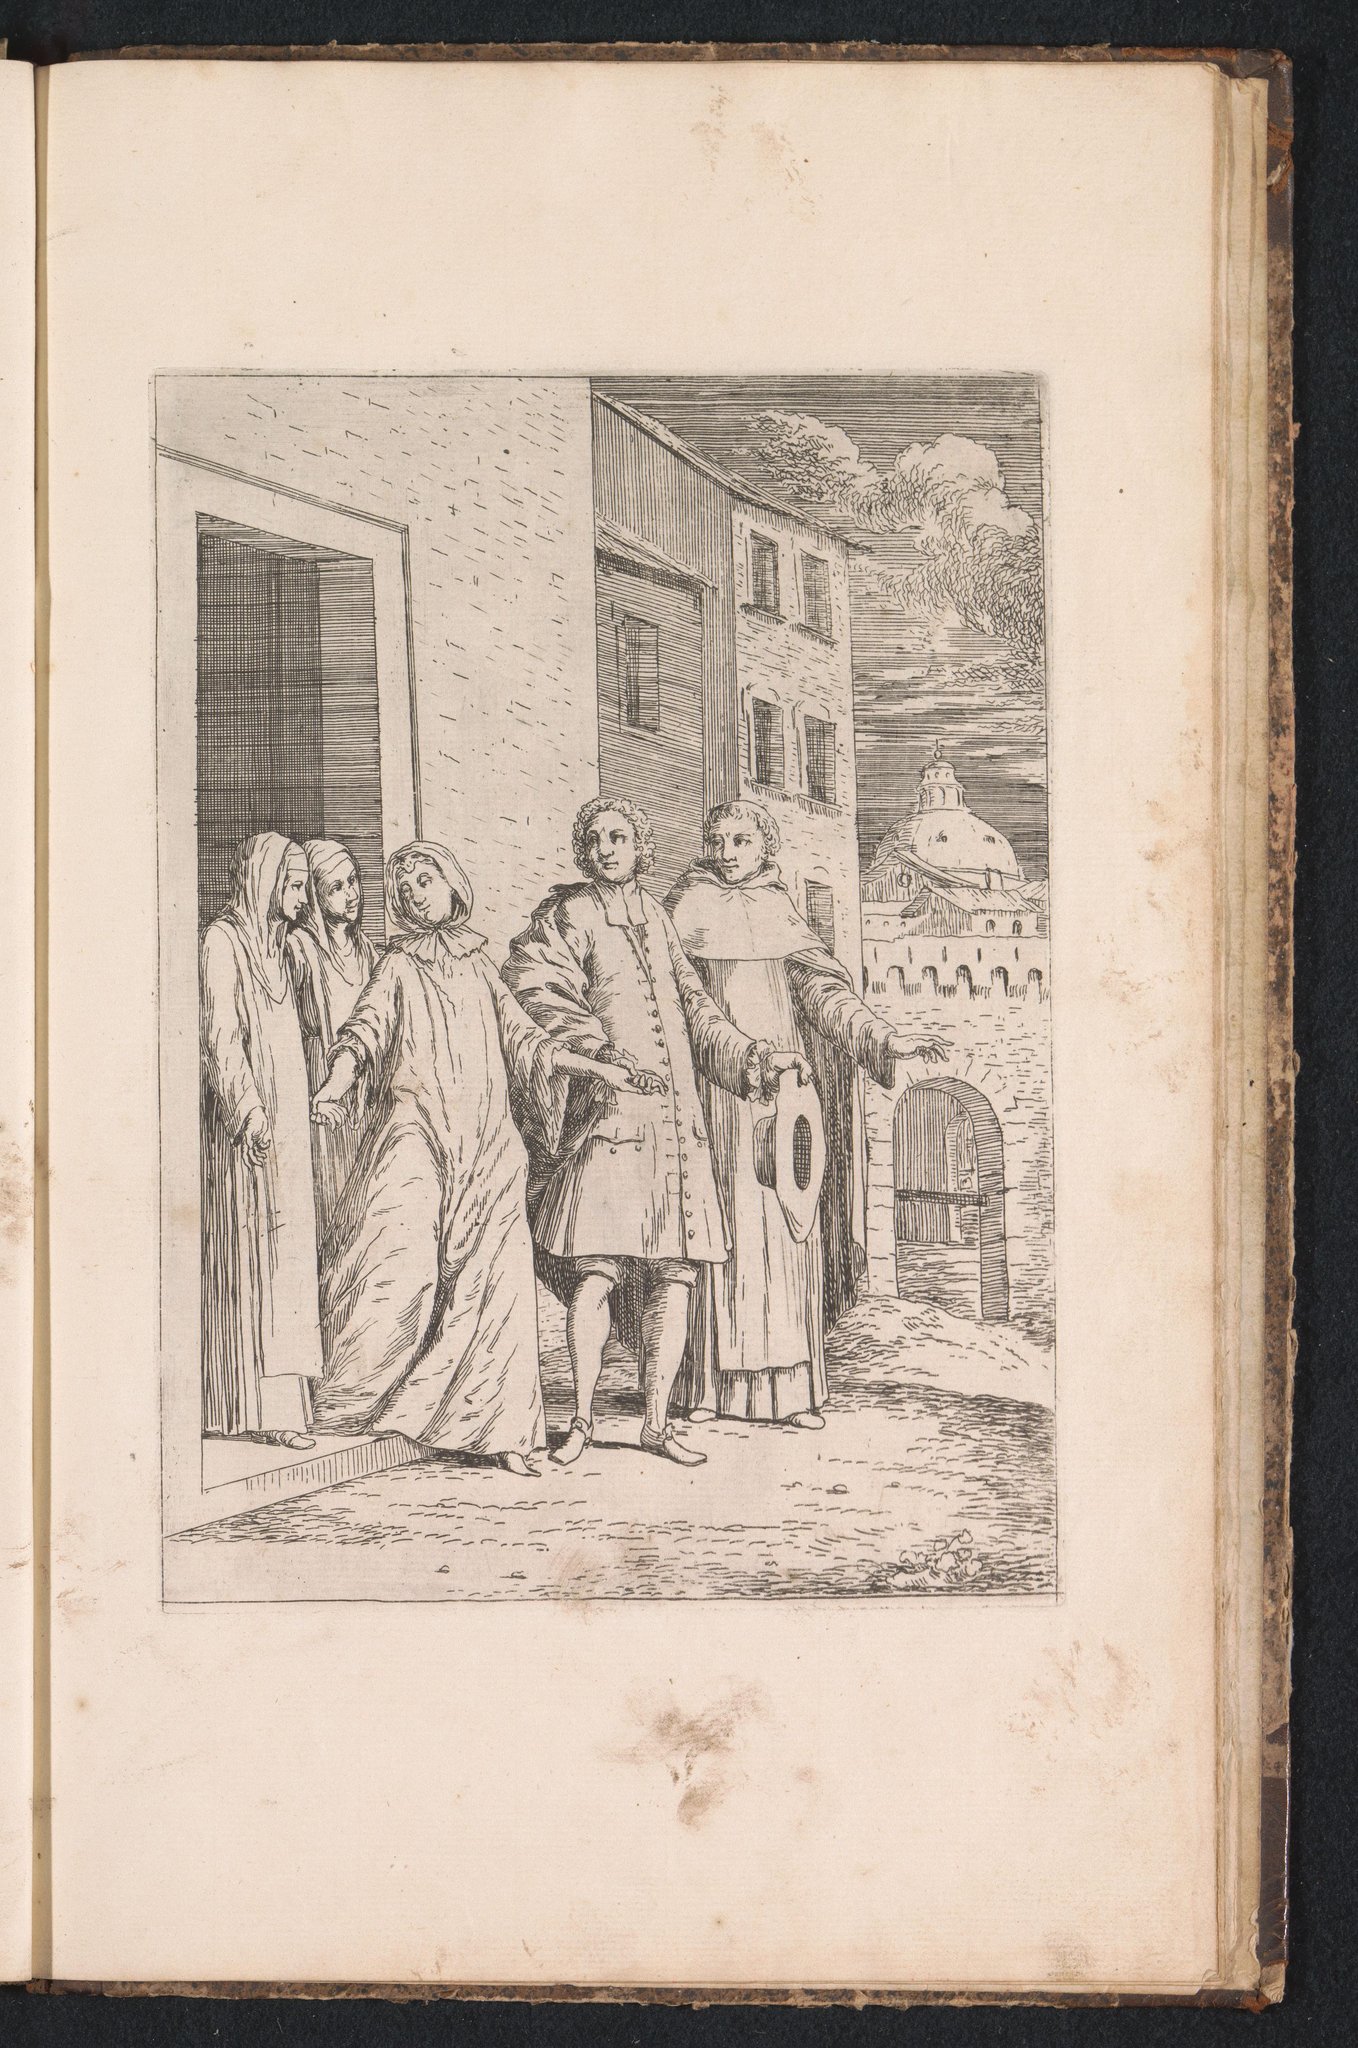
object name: print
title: Tableaux De l'Histoire Du Pere Jean Baptiste Girard & Marie Catherine Cadiere en XXXII Estampes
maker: jacques gabriel huquier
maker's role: draughtsman, painter, print maker, publisher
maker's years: 1725-1805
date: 1735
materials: paper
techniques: etching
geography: france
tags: sexual abuses of monks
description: De bisschop van Toulon laat Marie-Catherine Cadière uit het klooster halen. Onderdeel van de reeks van 32, veelal erotisch getinte, prenten gewijd aan het schandaal rond Marie-Catherine Cadière en de Jezuïet Jean-Baptiste Girard in 1730-1731.